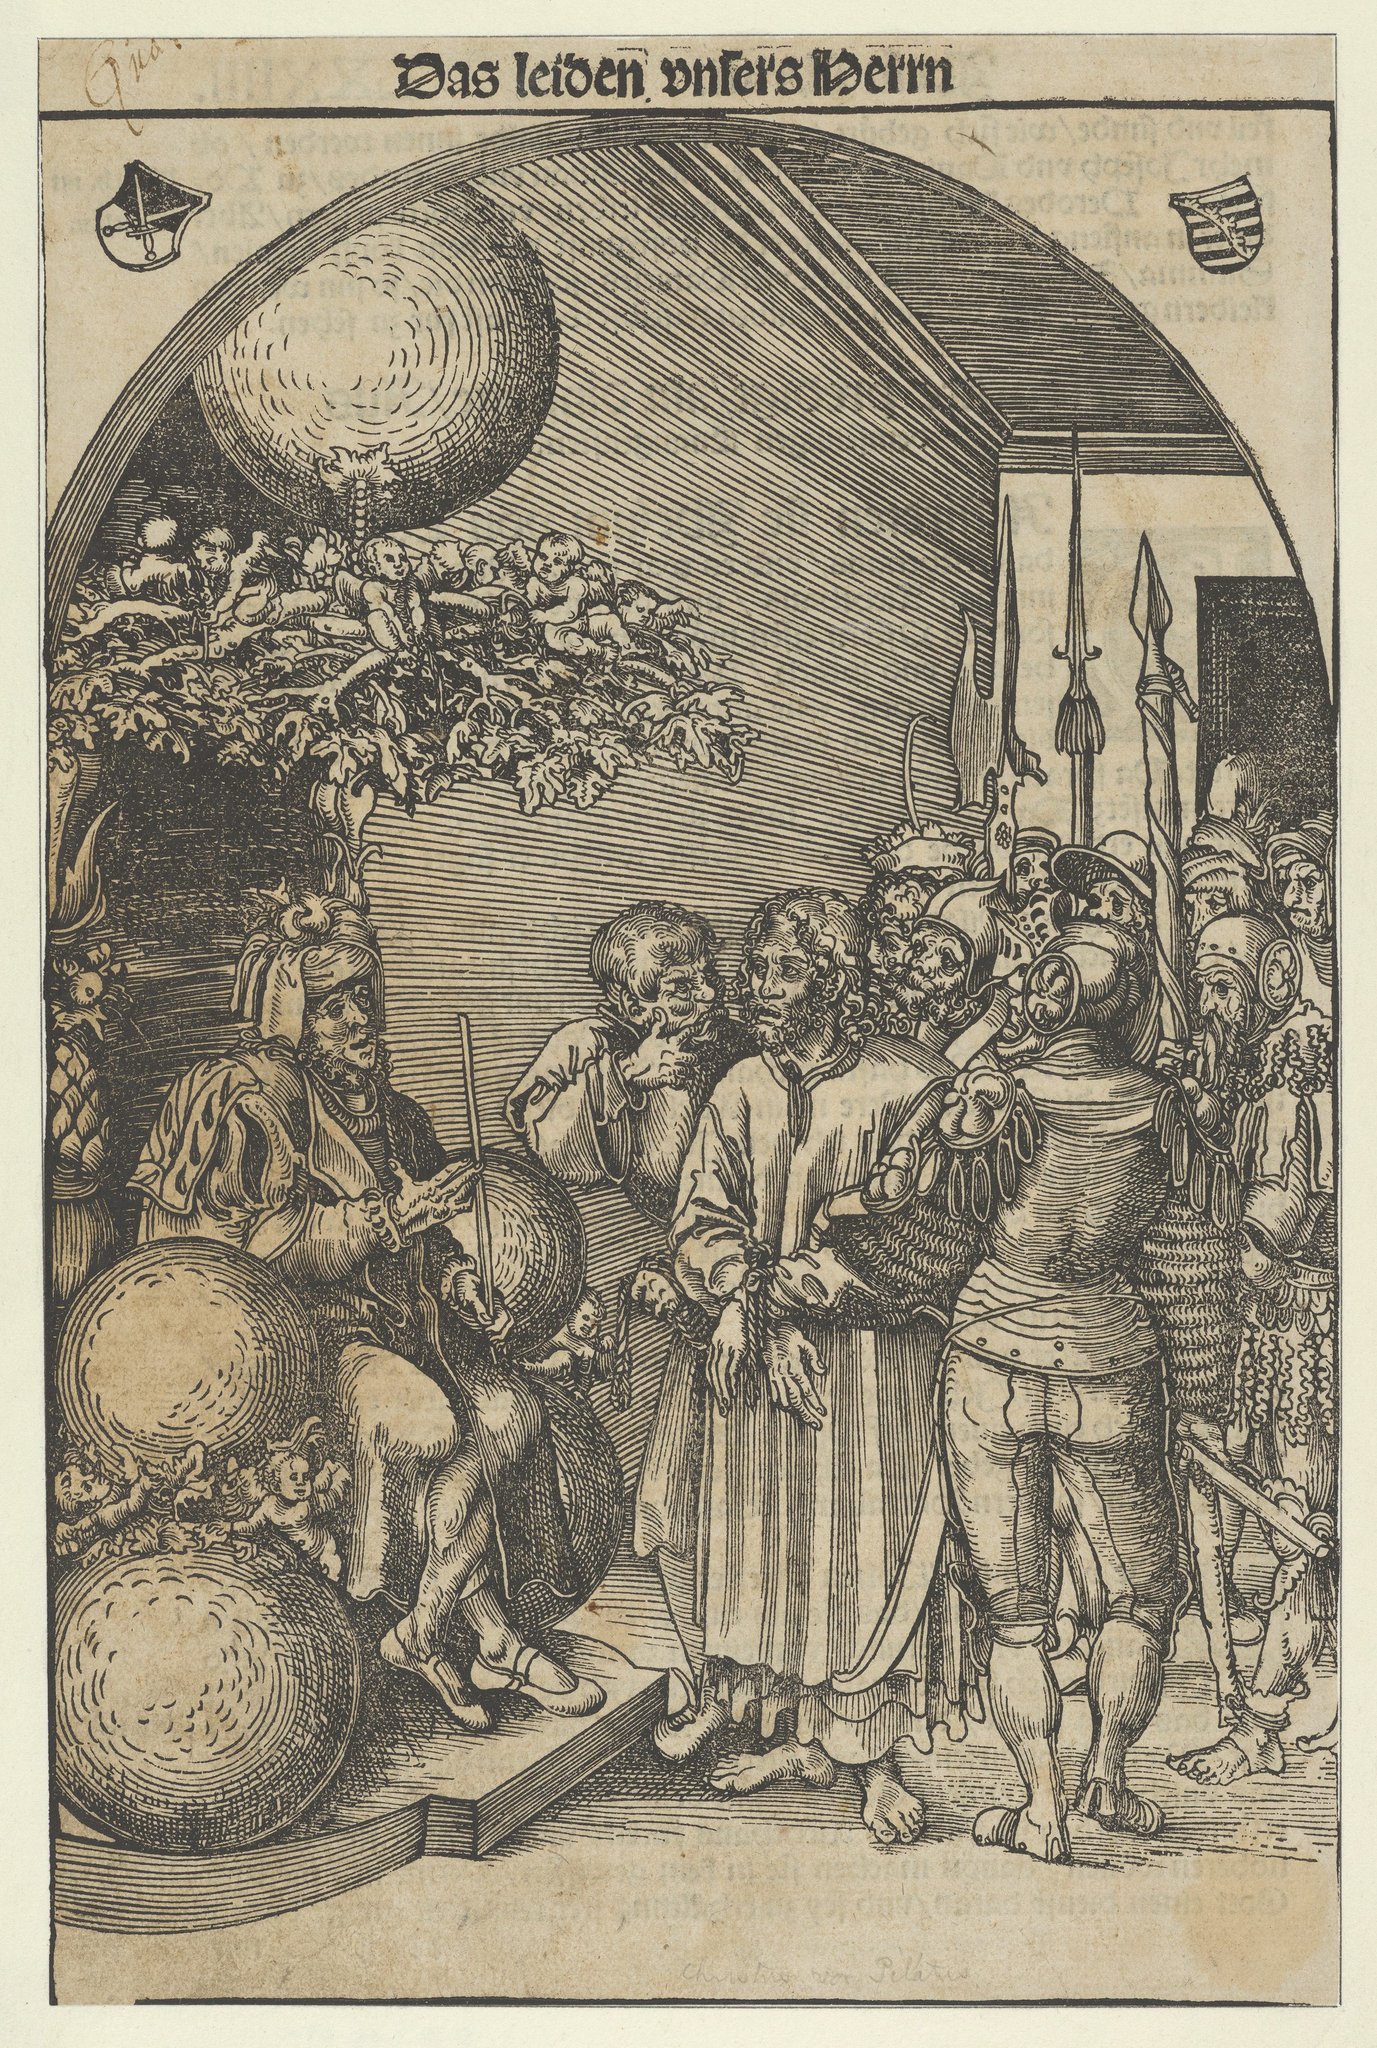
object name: print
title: Christ before Herod, from the Passion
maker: lucas cranach the elder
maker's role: artist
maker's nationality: german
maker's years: 1472-1553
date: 1492-1553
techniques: woodcut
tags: soldiers,men,christ,herod